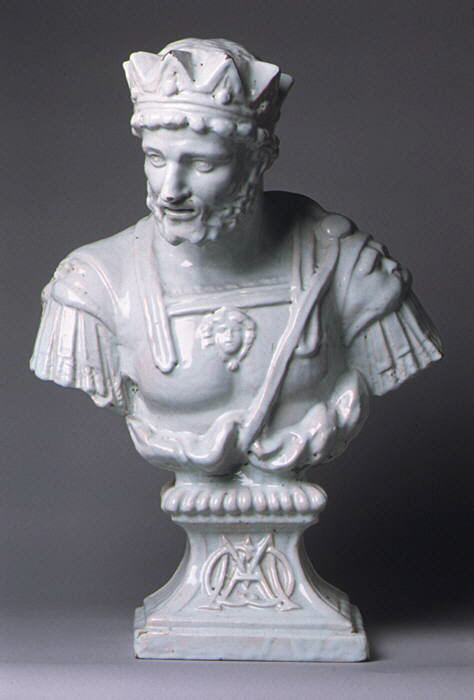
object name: bust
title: Bust of Mark Antony (one of a pair)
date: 1720-1730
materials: earthenware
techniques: glazing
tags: mark antony,portraits,insignia